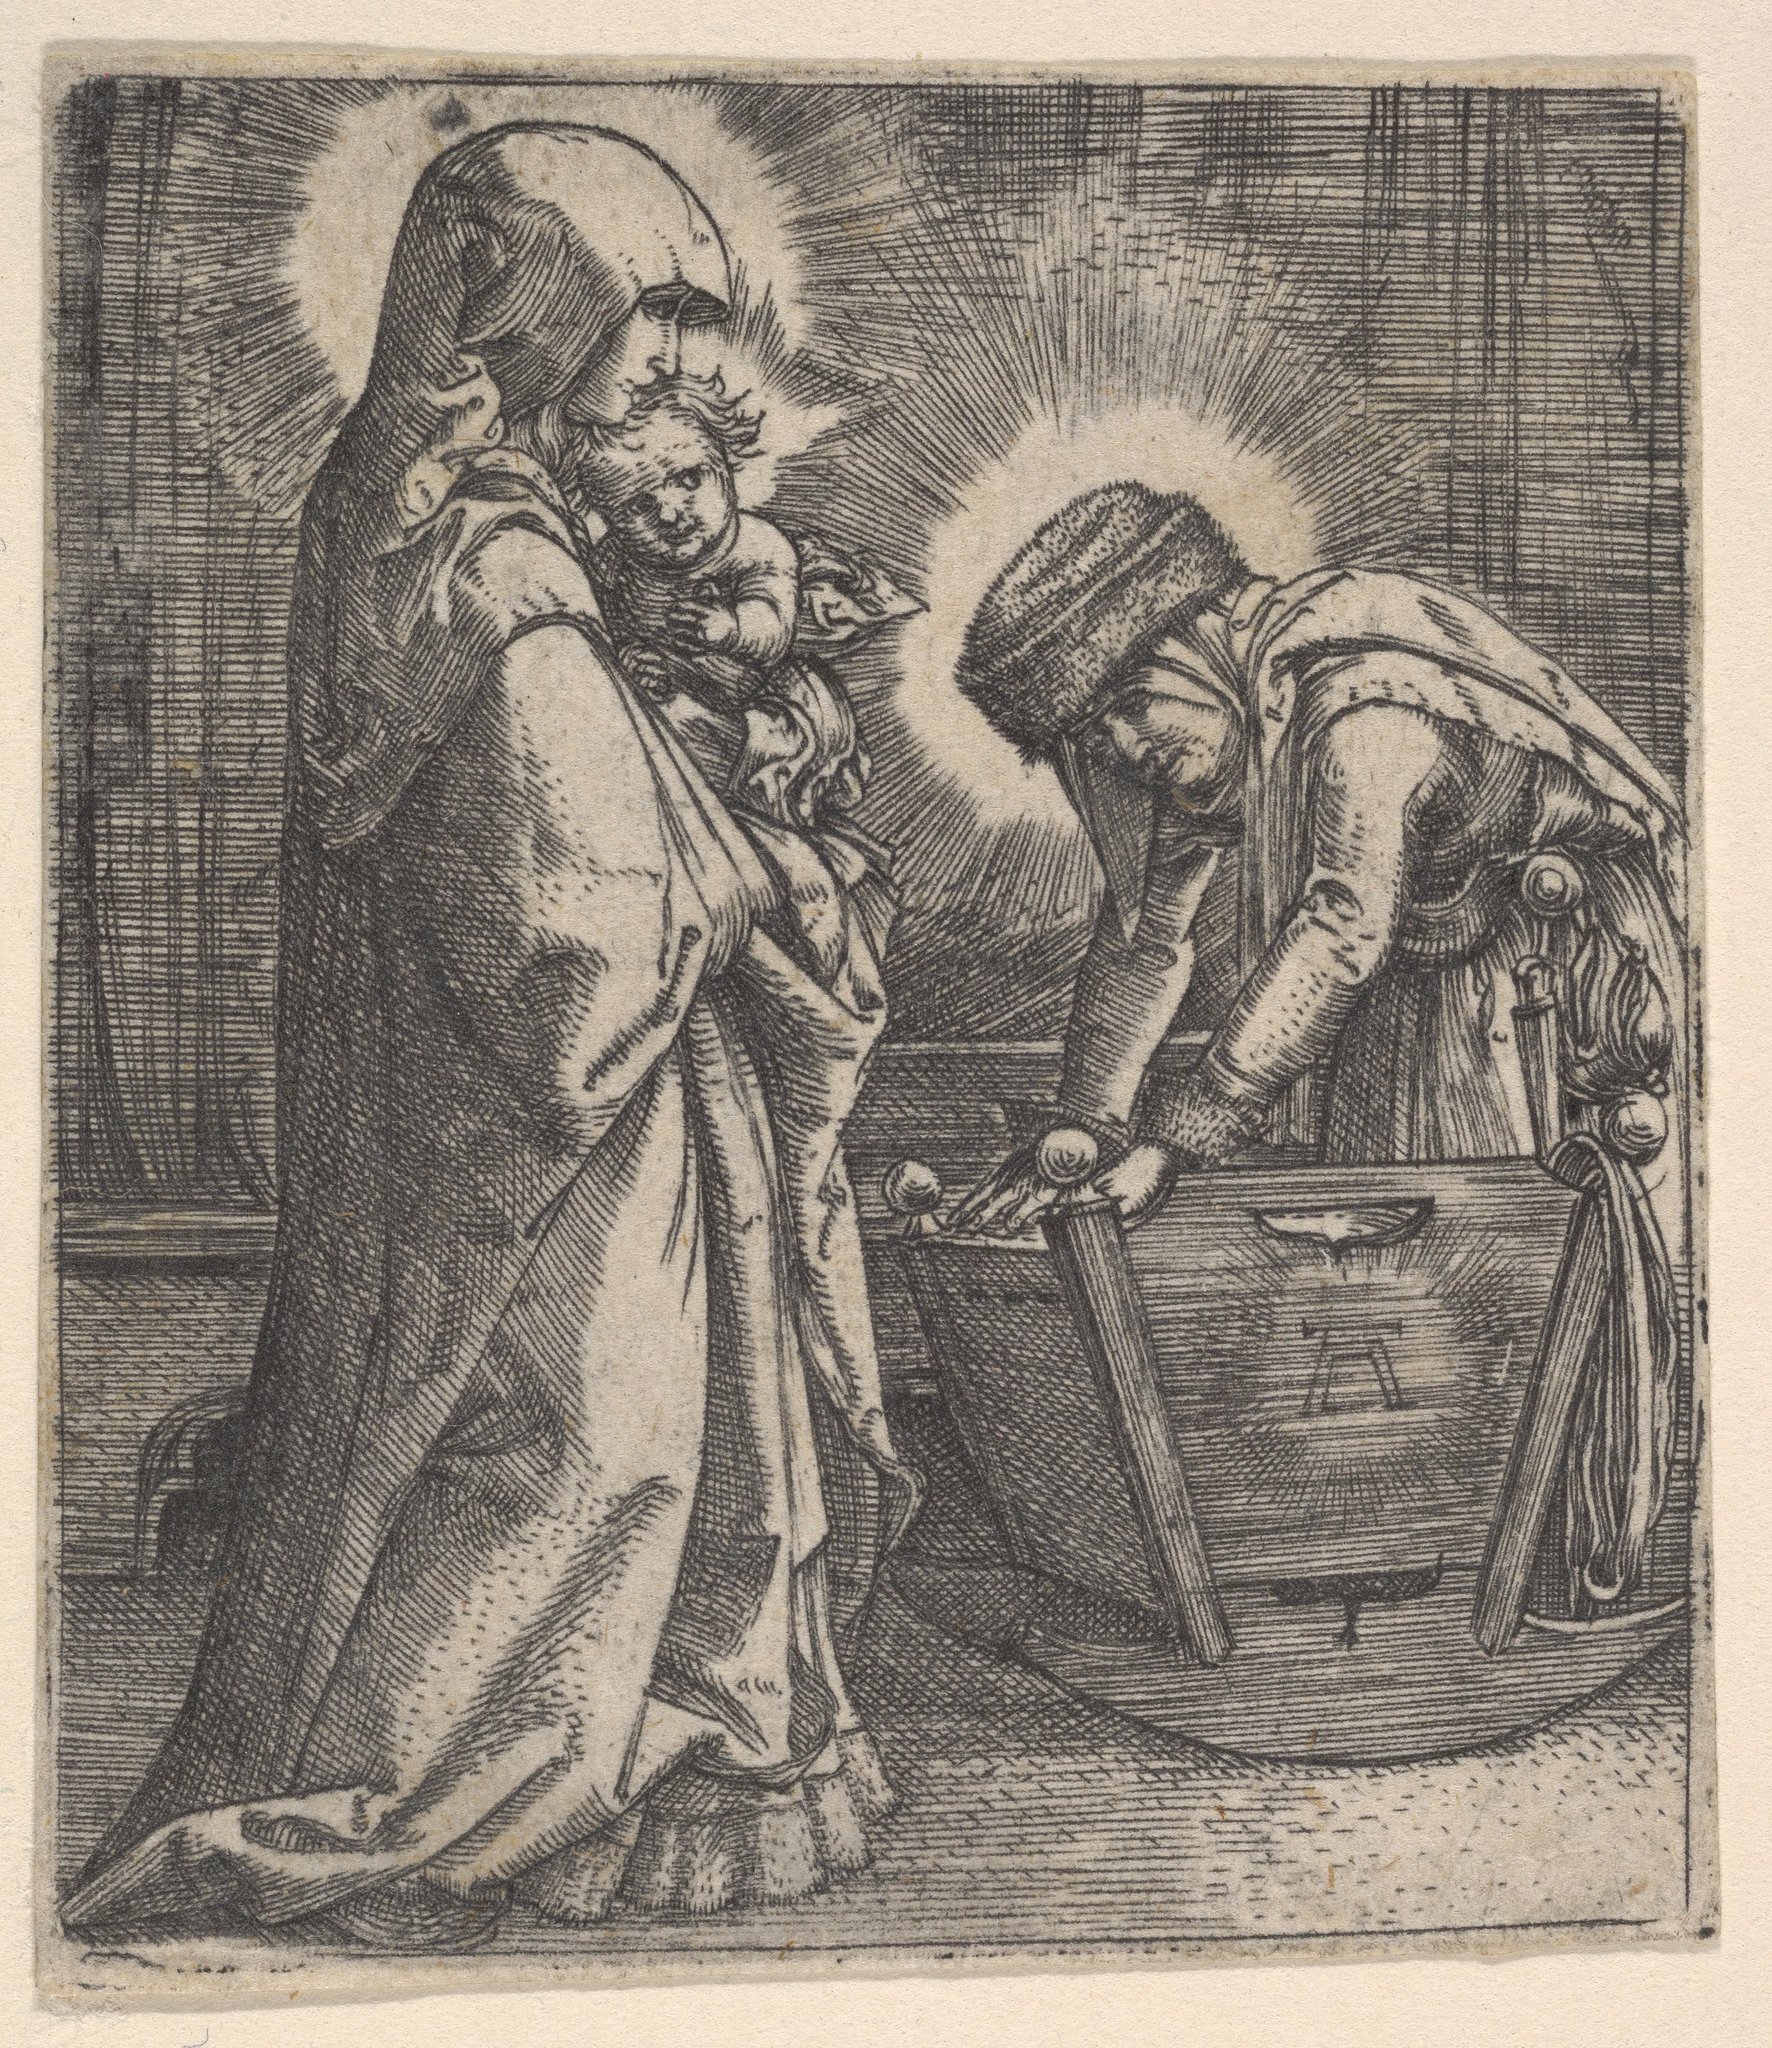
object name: print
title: The Virgin and Child with Saint Anne at the Cradle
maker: albrecht altdorfer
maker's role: artist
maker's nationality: german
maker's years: 1480-1538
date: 1500-1538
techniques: engraving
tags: madonna and child,saint anne,cradles